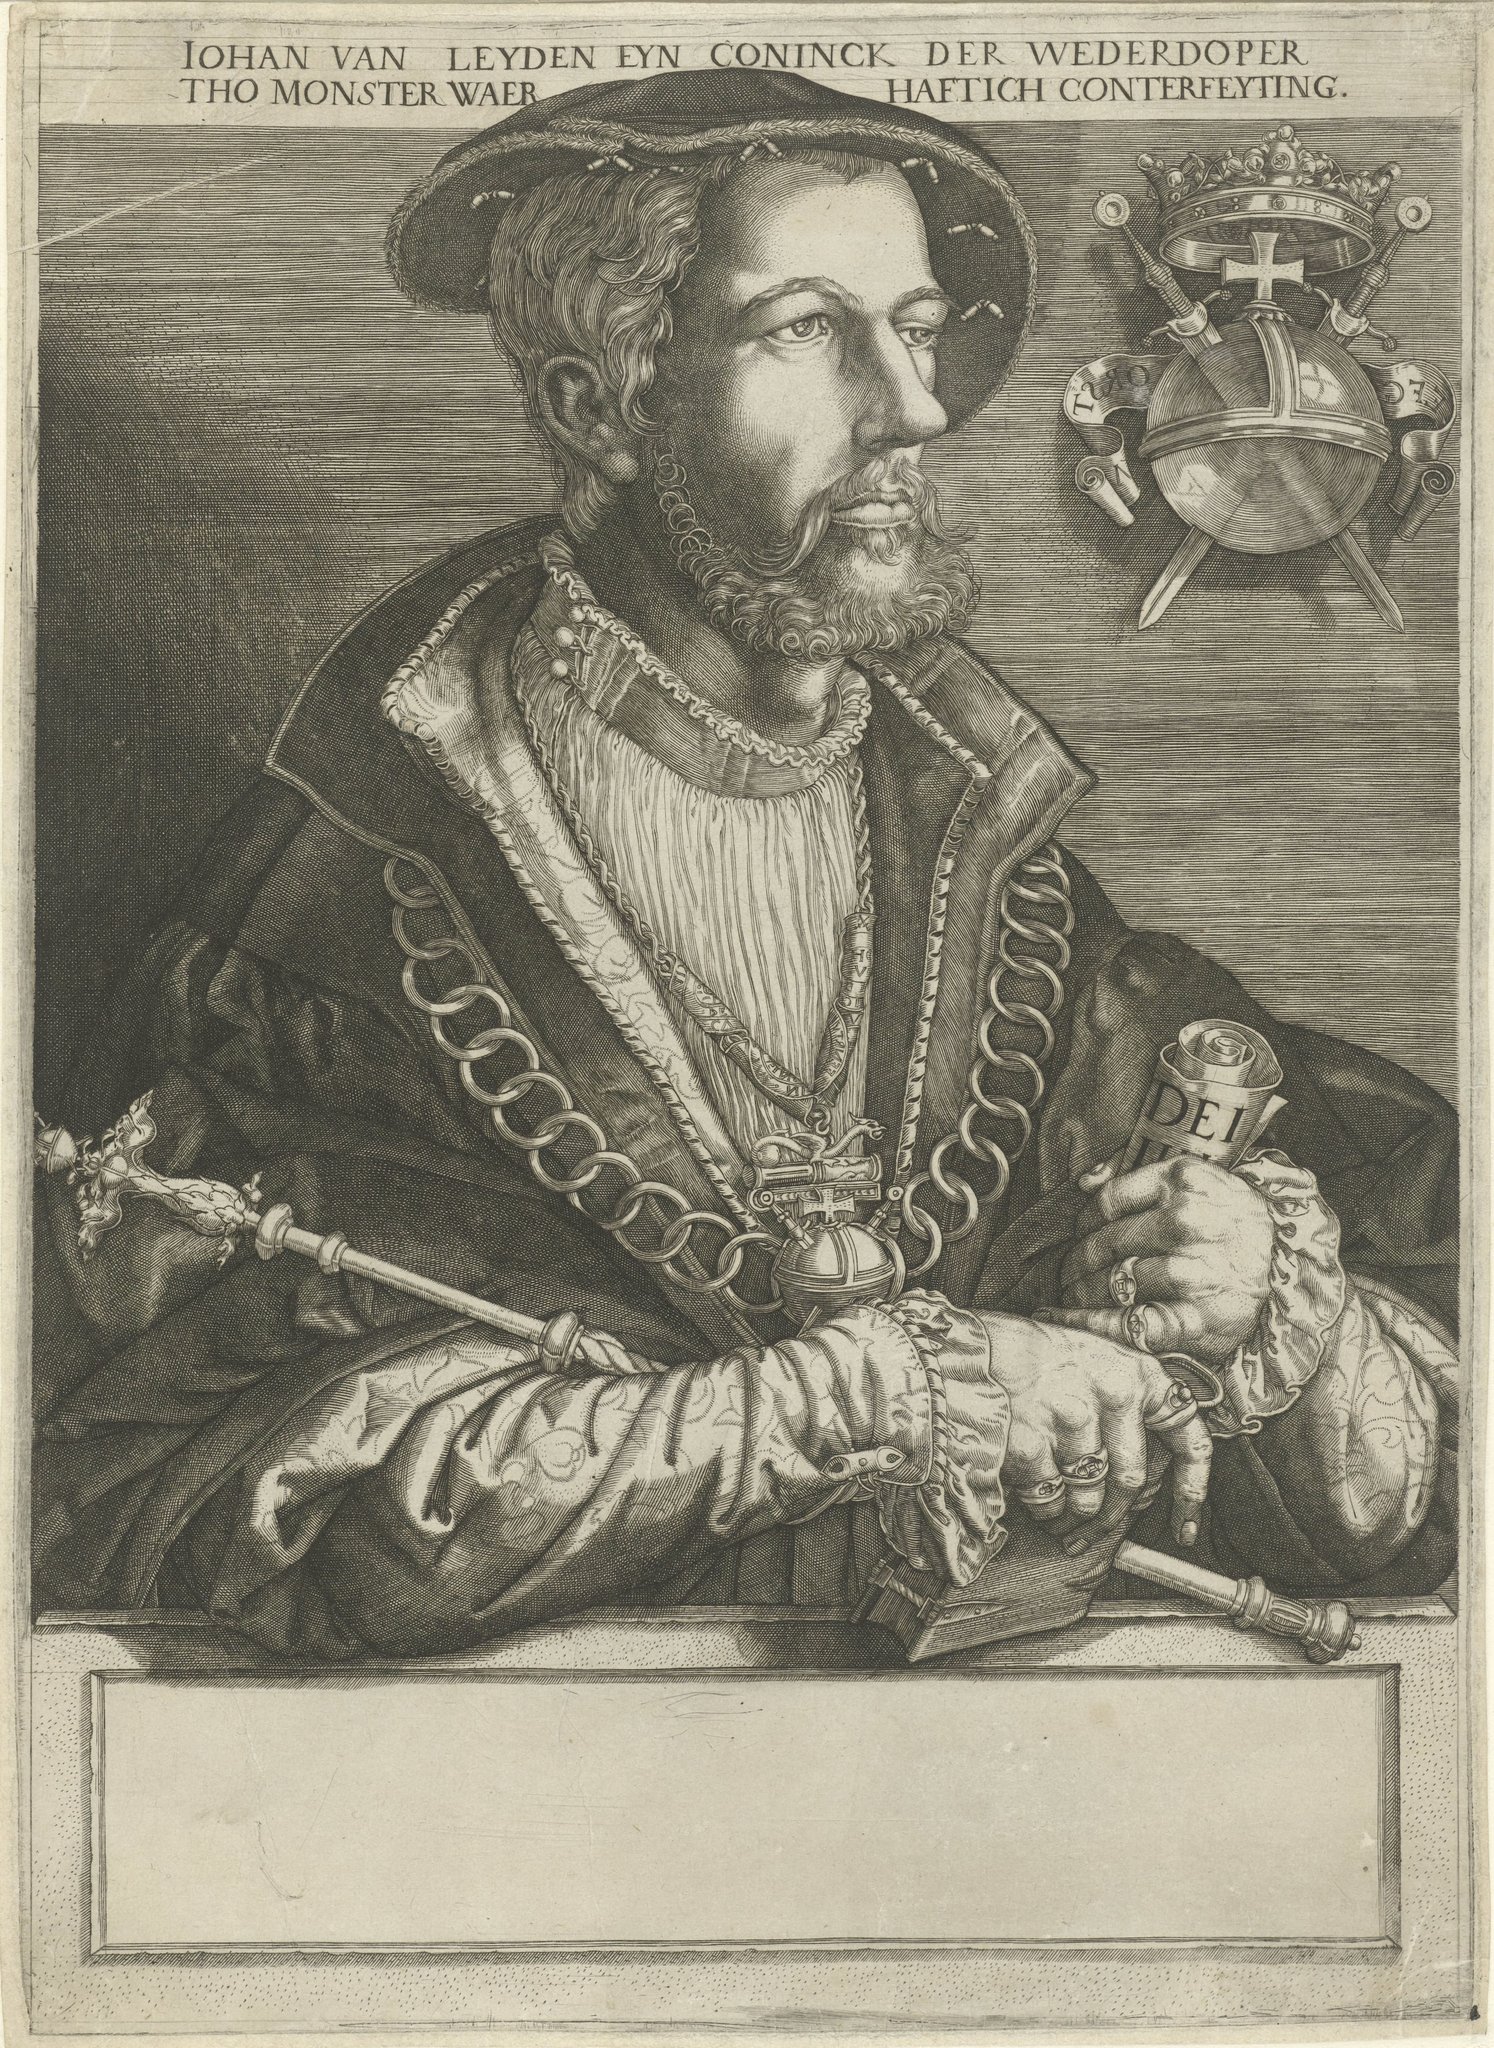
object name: print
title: Portret van Jan Beukelszoon van Leiden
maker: jan harmensz. muller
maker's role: draughtsman, print maker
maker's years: 1571-1628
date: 1613-1617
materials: paper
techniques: engraving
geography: amsterdam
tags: leiden, orb (symbol of sovereignty; sphere with cross on top), sceptre, staff (symbol of sovereignty)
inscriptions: collector's mark: Lugt 240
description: Portret van Jan Beukelszoon van Leiden, leider en zelfuitgeroepen koning van de wederdopers in Münster. Om zijn hals een ketting, onder de arm een scepter en in zijn handen een Bijbel en een pamflet. Rechtsboven een gekroonde rijksappel, doorboord met twee zwaarden. Onderaan een vierregelig vers in het Latijn.